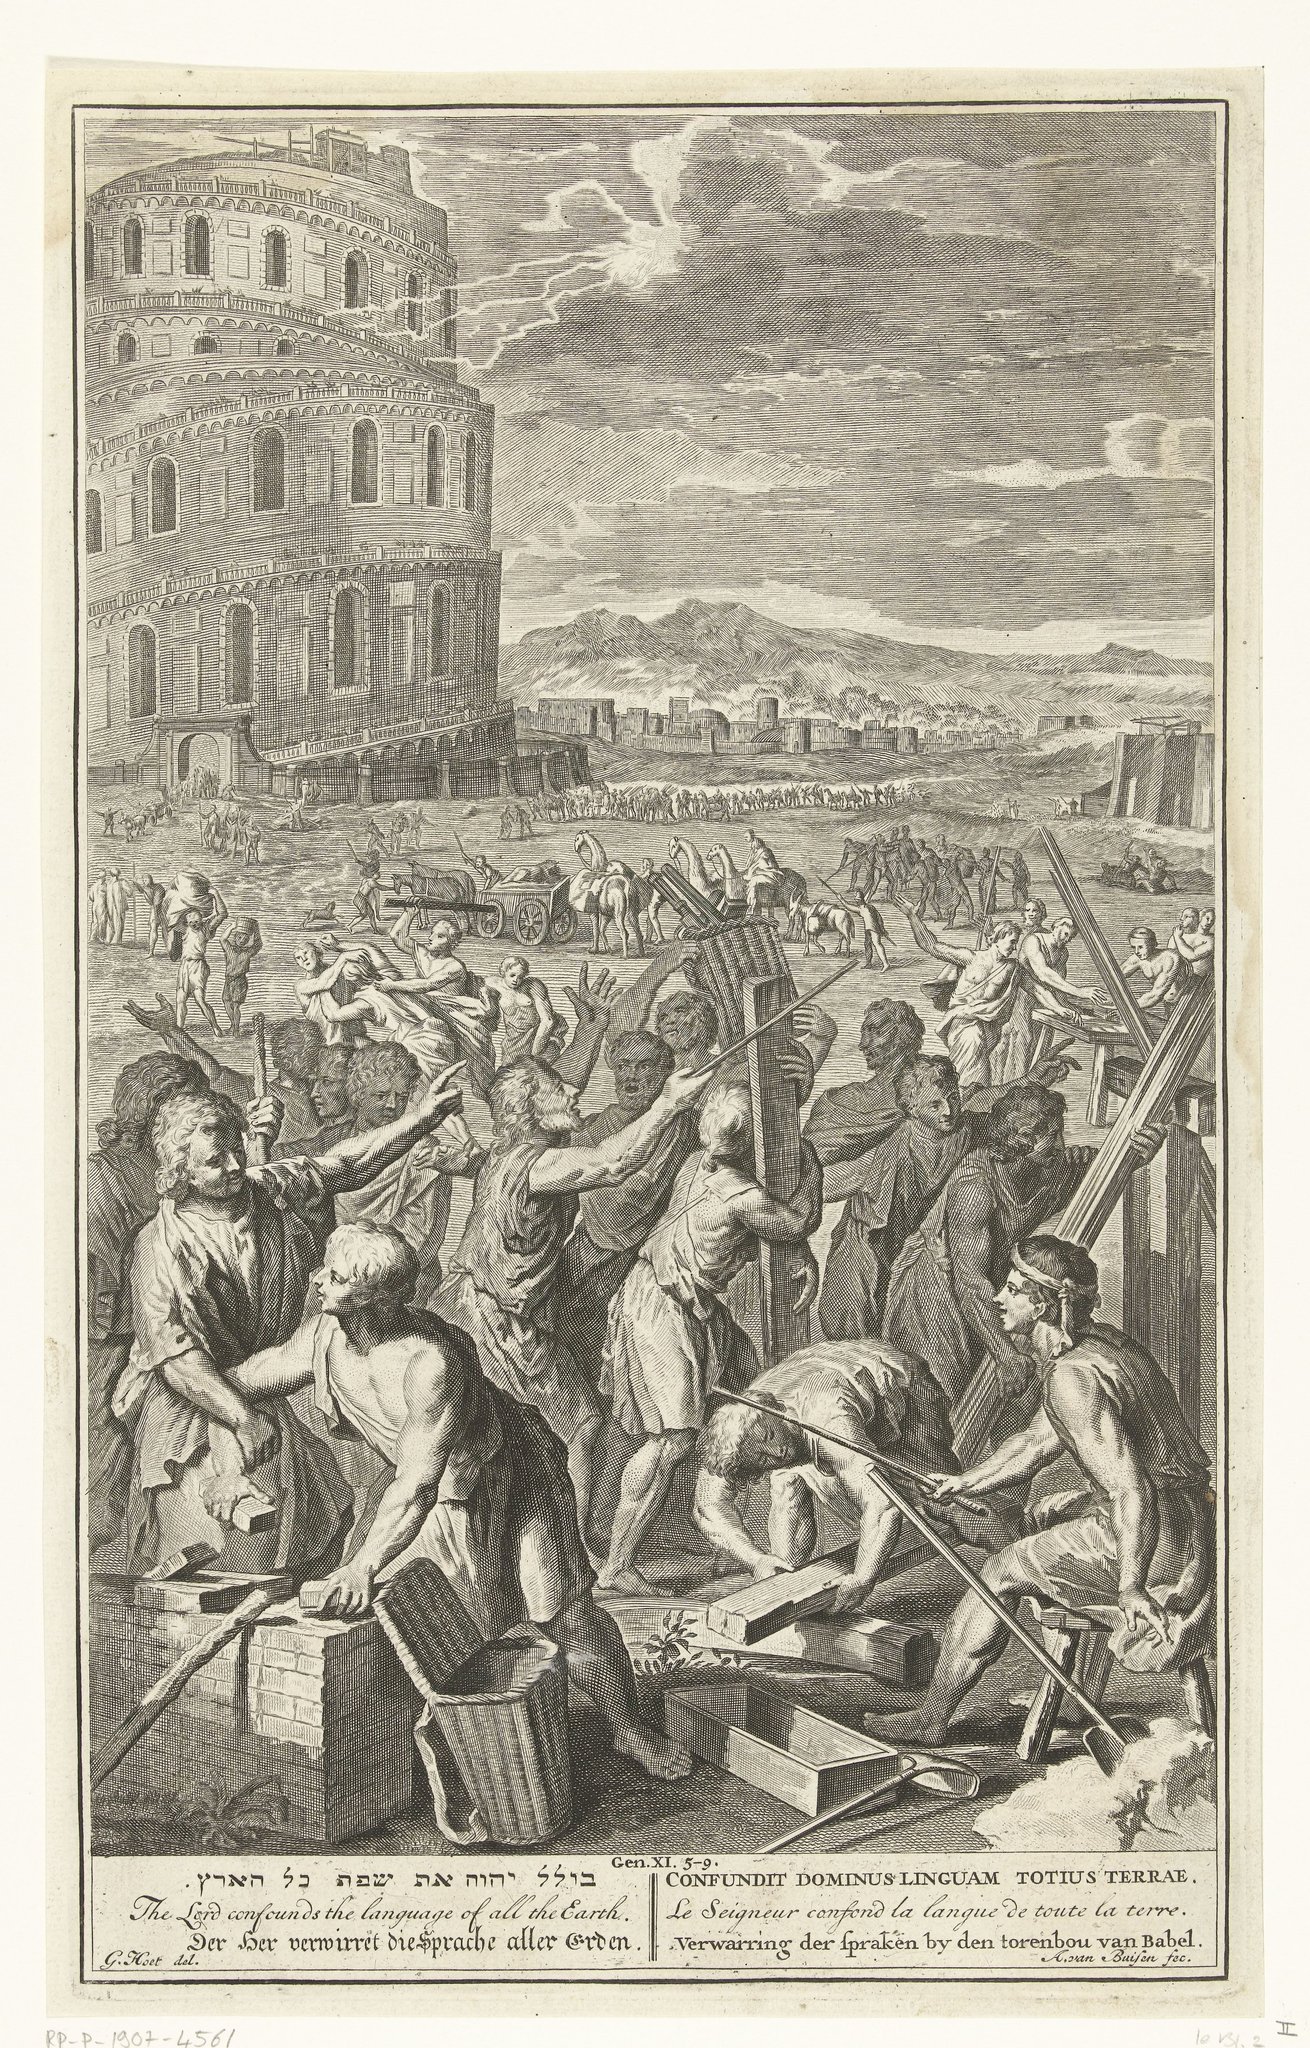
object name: print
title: Verwarring der spraken by den torenbou van Babel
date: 1711-1720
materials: paper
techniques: engraving, etching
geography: amsterdam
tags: the confusion of languages and the scattering of people over the earth ~ story of the tower of babel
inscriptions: collector's mark: Lugt 2228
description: De bouw van de toren te Babel. De mensen die aan de toren werken kunnen elkaars taal niet verstaan, dit bemoeilijkt het werk aan dit enorme bouwwerk. Illustratie voor het Oude Testament, Gen. 11, 5-9. Onder de voorstelling een titel in het Hebreeuws, Engels, Duits, Latijn, Frans en Nederlands.